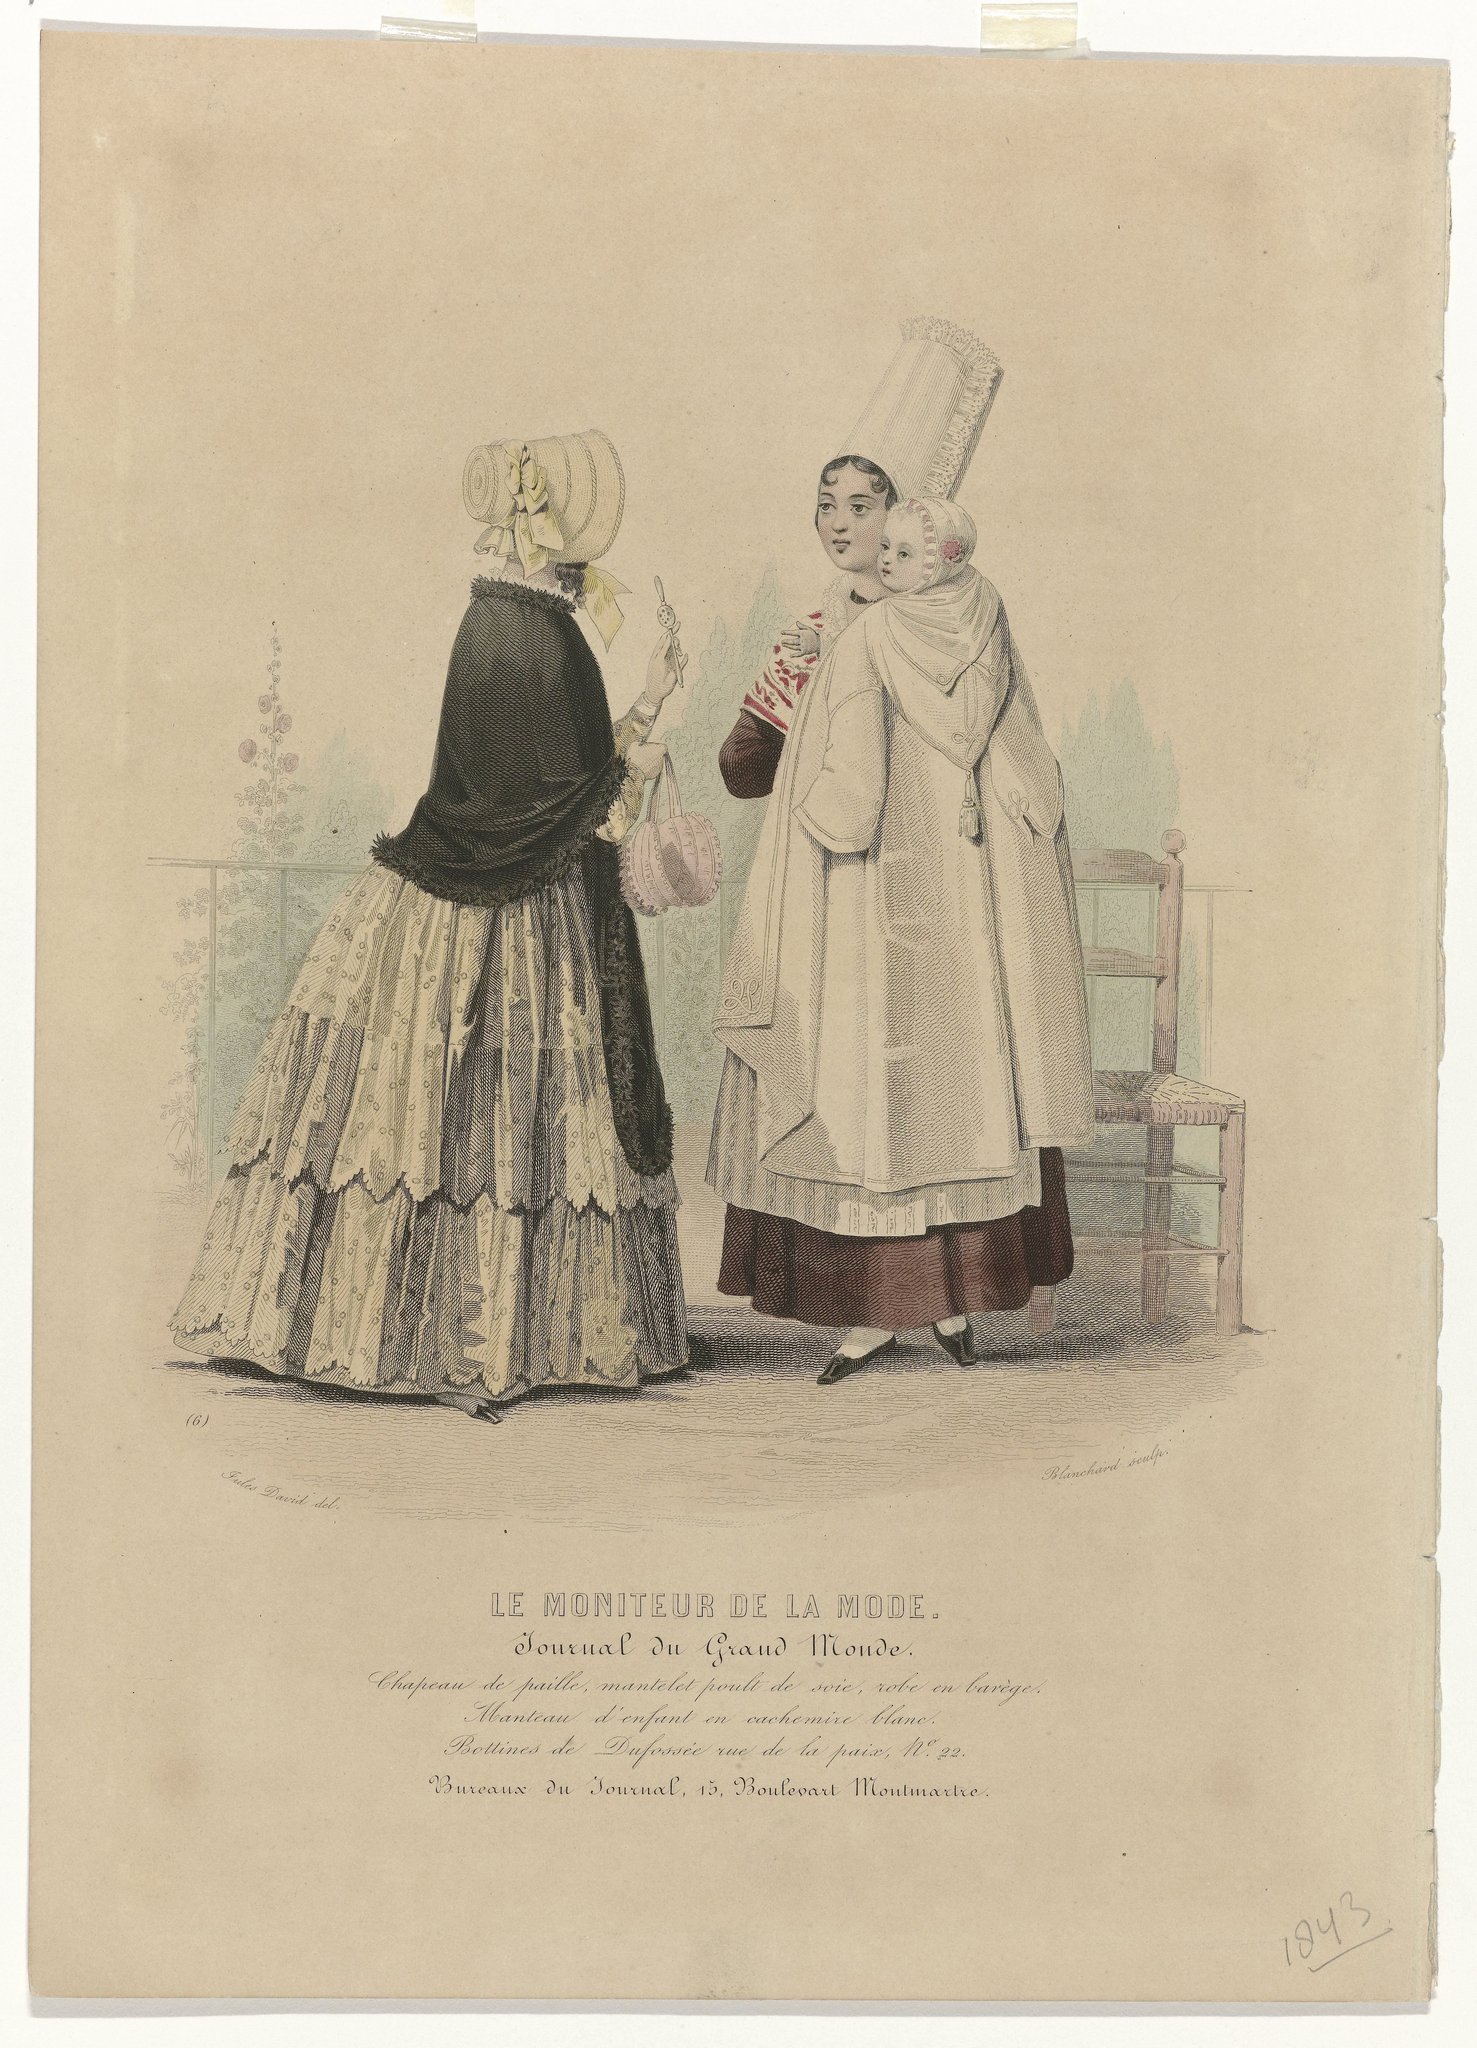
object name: fashion print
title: Le Moniteur de la Mode, 1843, No. 6 : Chapeau de paill (...)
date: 1843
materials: paper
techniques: engraving, hand coloring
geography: paris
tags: head-gear (+ children's clothes), clothing for the upper part of the body (mantelet) (+ women's clothes), fashion plates, head-gear: hat (+ women's clothes), shoes, sandals (+ women's clothes), dress, gown (+ women's clothes), rattle (child's toy)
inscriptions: caption: ‘Chapeau de paille, mantelet poult de soie, robe en barège. Manteau d'enfant en cachemire blanc. Bottines de Dufossée rue de la paix, No. 22.’, address: ‘Bureaux du Journal, 15, Boulevart Montmartre.’, title: ‘Le Moniteur de la Mode. / Journal du Grand Monde’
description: Vrouw met een ratel en kindermuts in de hand, staande bij een vrouw met een baby op de arm. Volgens het onderschrift: hoed van stro. Kleine schoudermantel van 'poult de soie'. Japon van 'barège'. Kindermantel van witte kasjmier. Halfhoge laarzen van Dufossée. Prent uit het modetijdschrift Le Moniteur de la Mode (1843-1913).